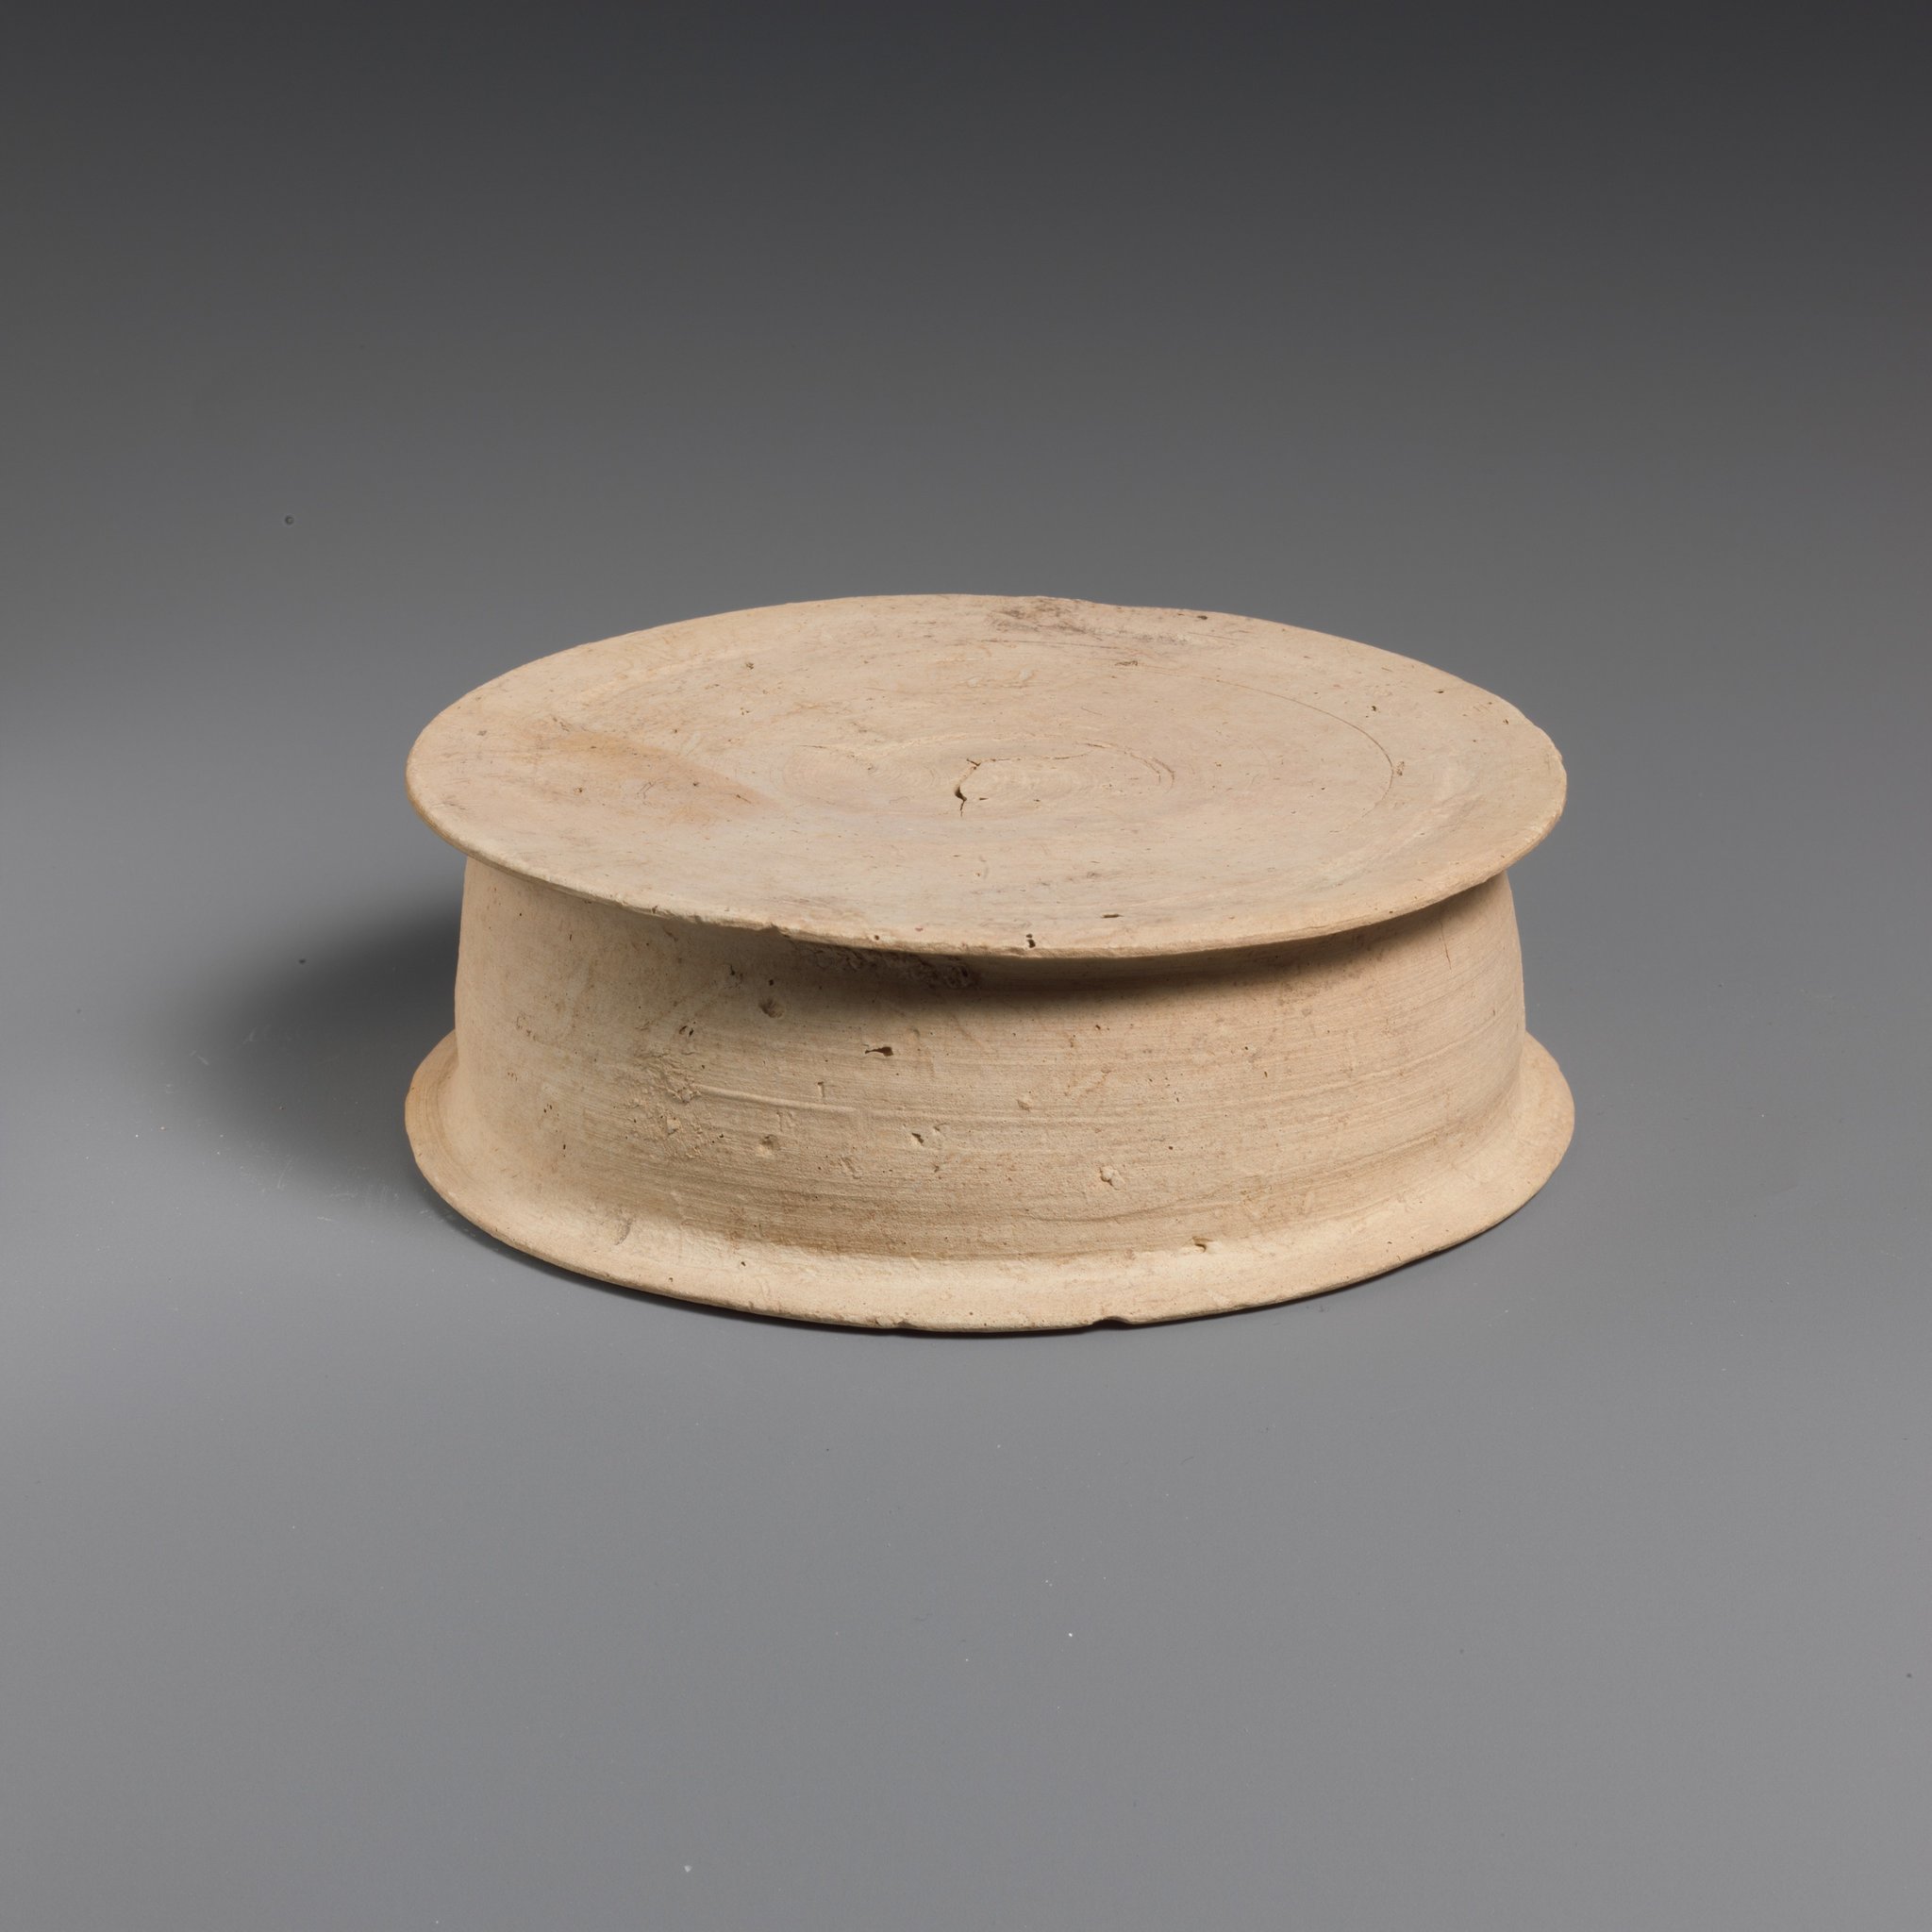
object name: statue base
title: Terracotta statuette base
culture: greek, south italian, tarentine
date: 300-201 BCE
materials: terracotta